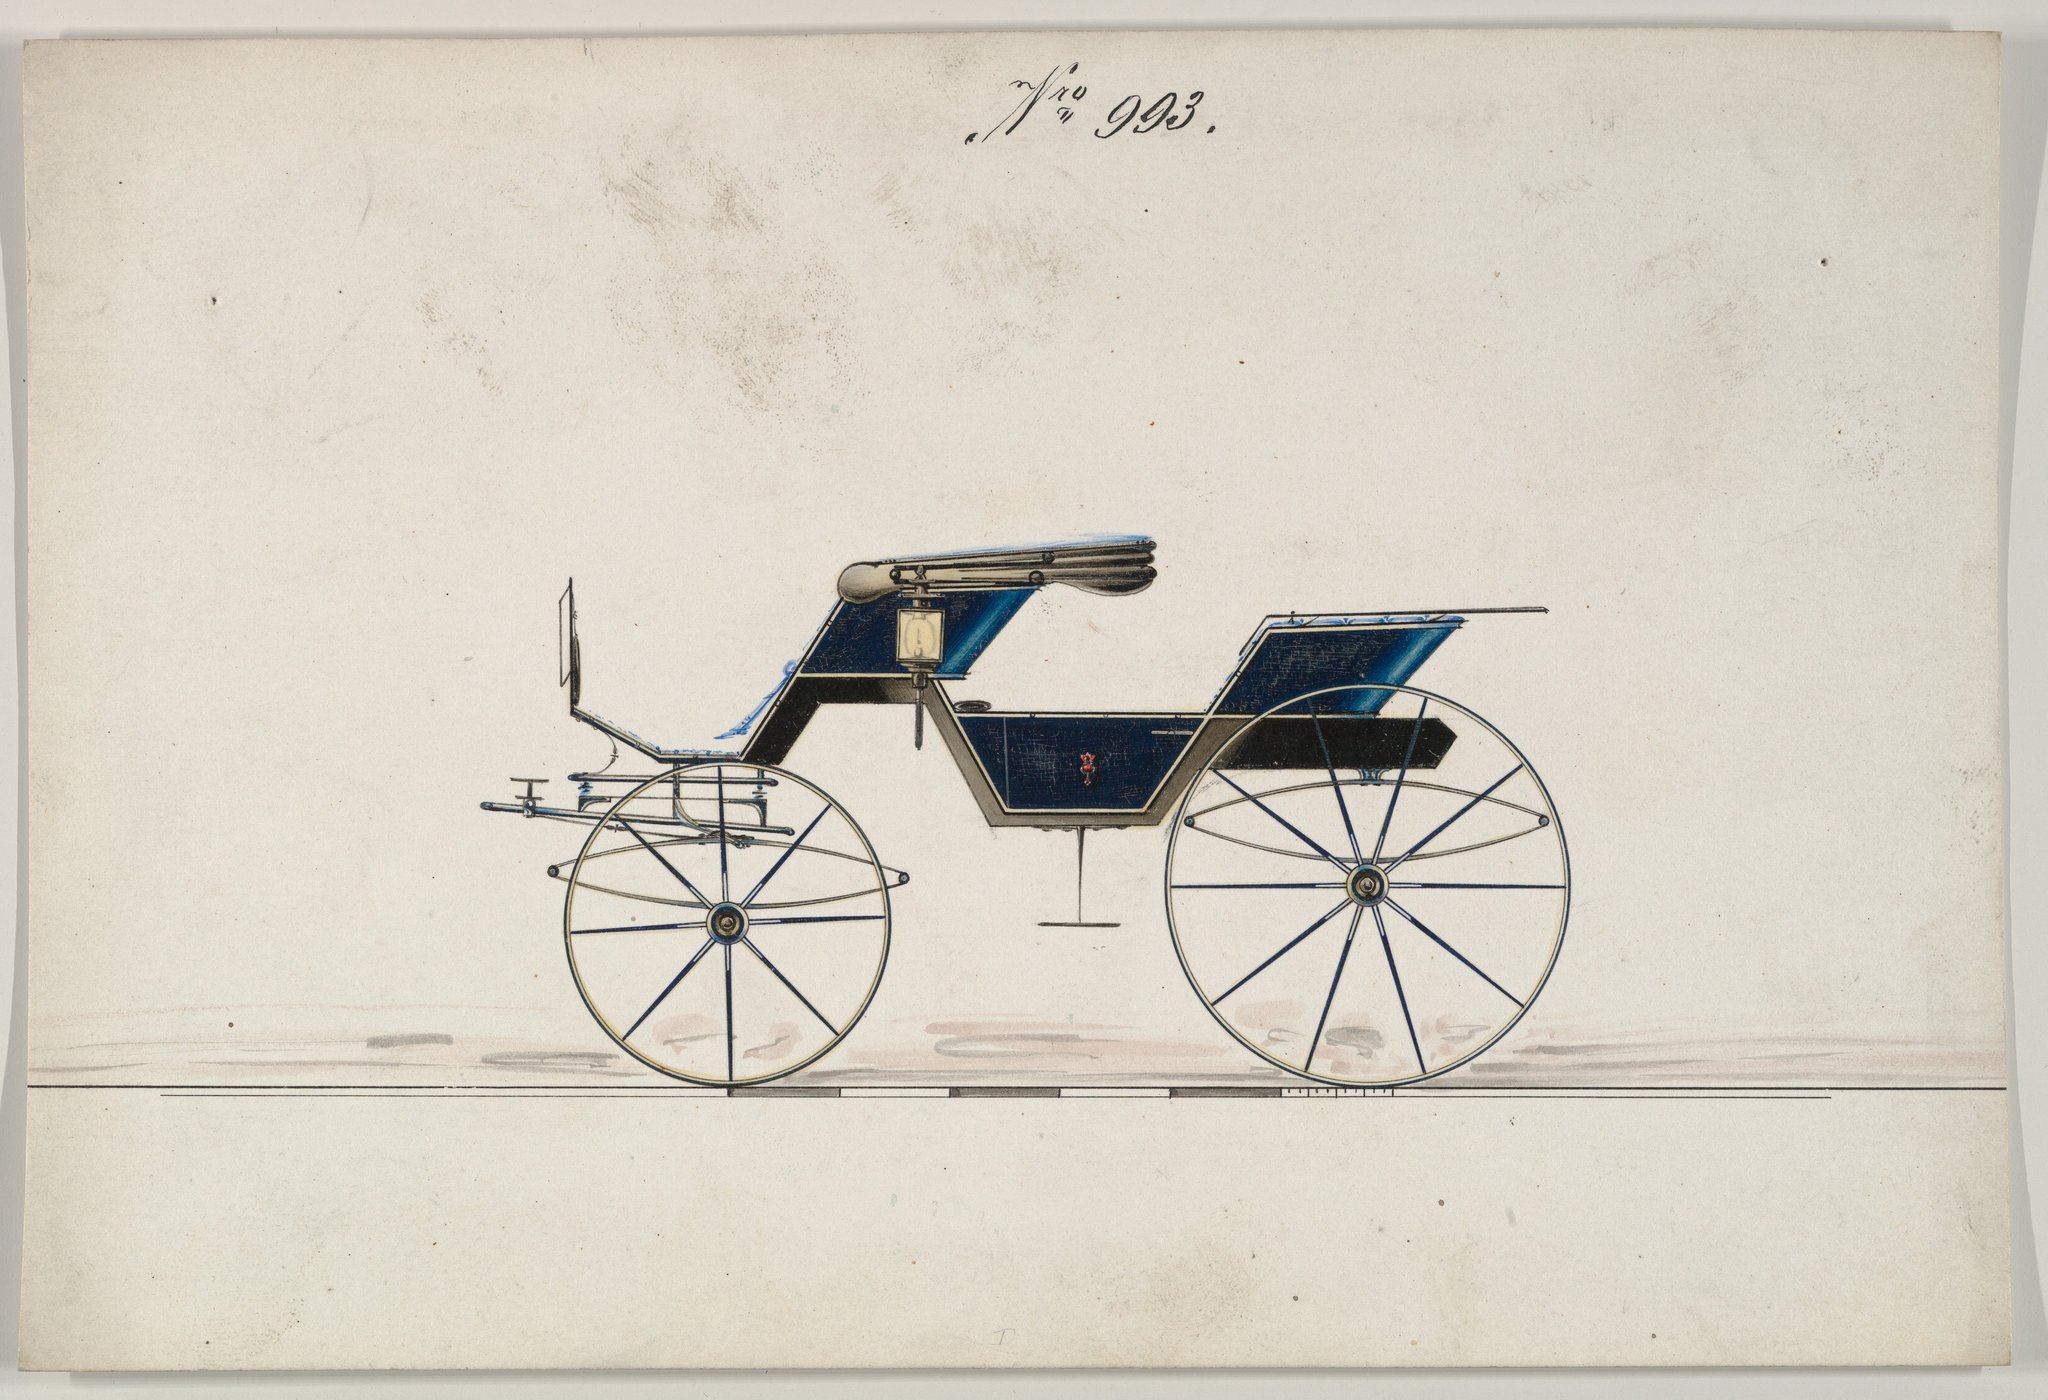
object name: drawing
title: Design for Phaeton, no. 993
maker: brewster & co.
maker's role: manufacturer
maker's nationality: american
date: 1850-1874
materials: gouache, gum arabic, ink, watercolor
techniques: pen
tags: carriages